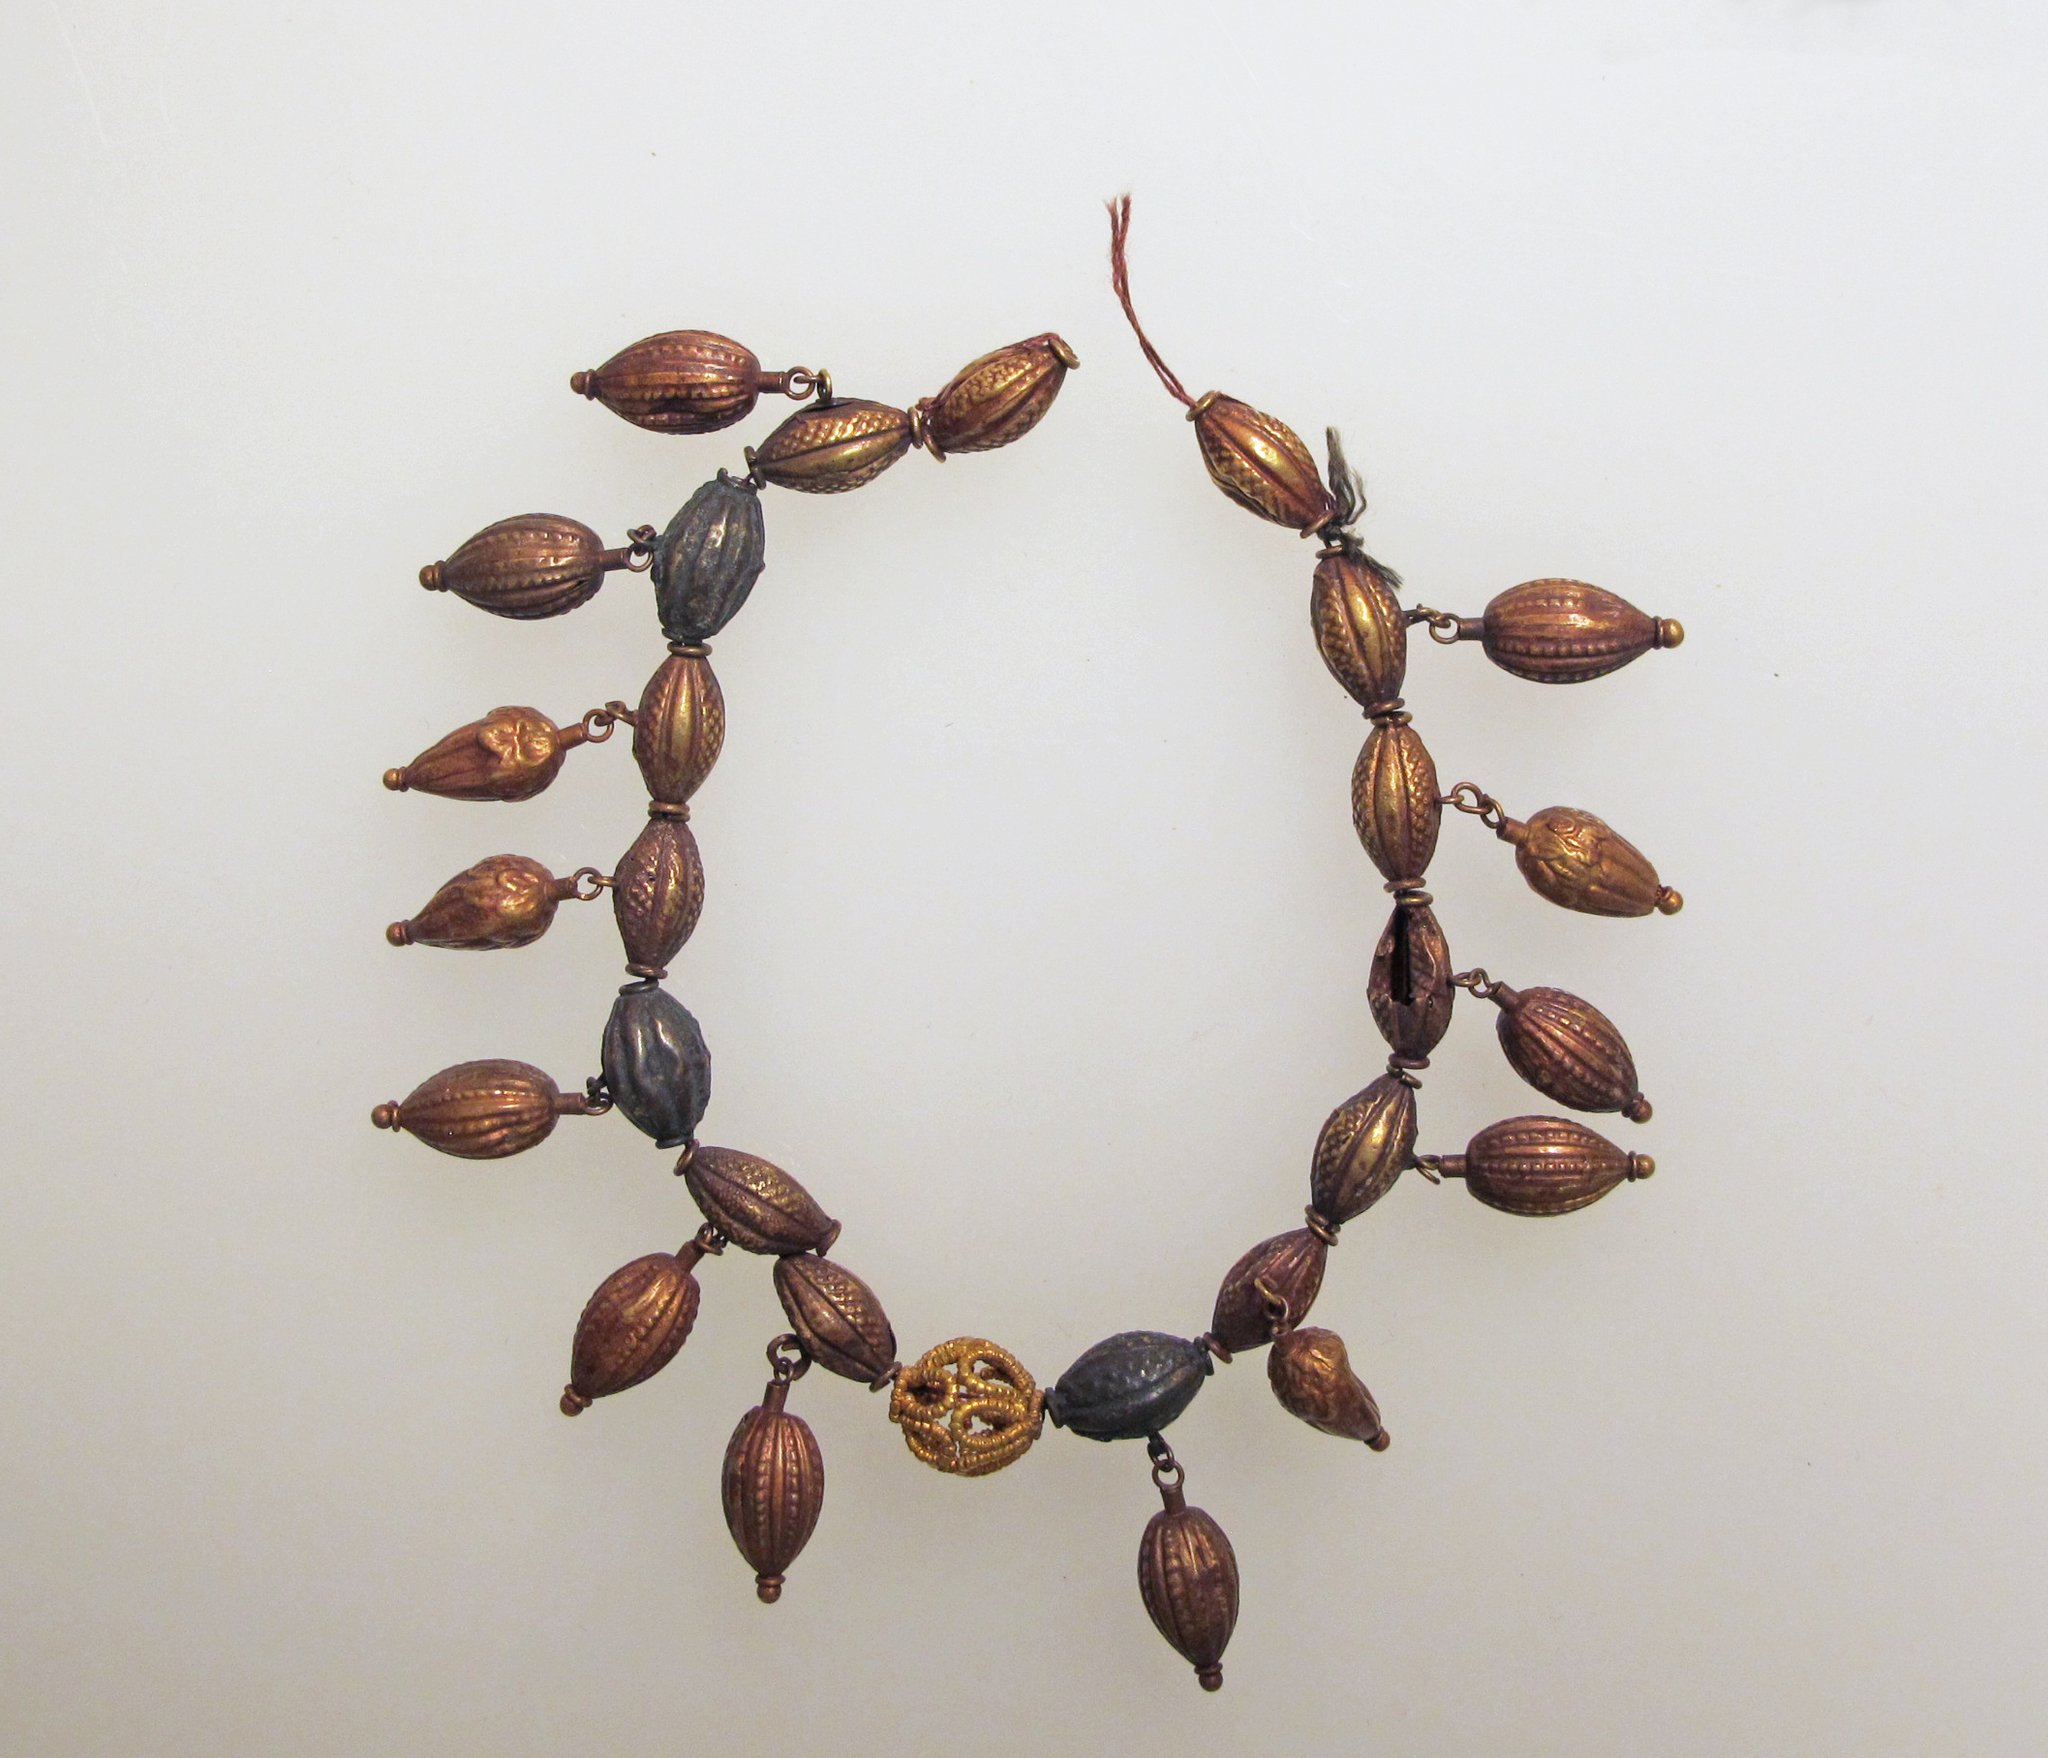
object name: pendant jewelry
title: Necklace with pendants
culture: roman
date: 201-300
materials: gold